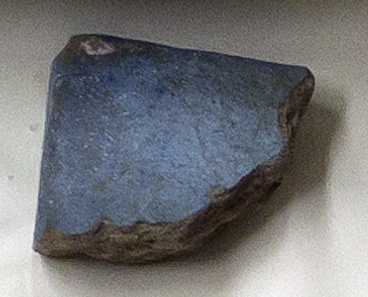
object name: menat fragment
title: Votive Menat fragment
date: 1479-1458 BCE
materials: faience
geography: egypt